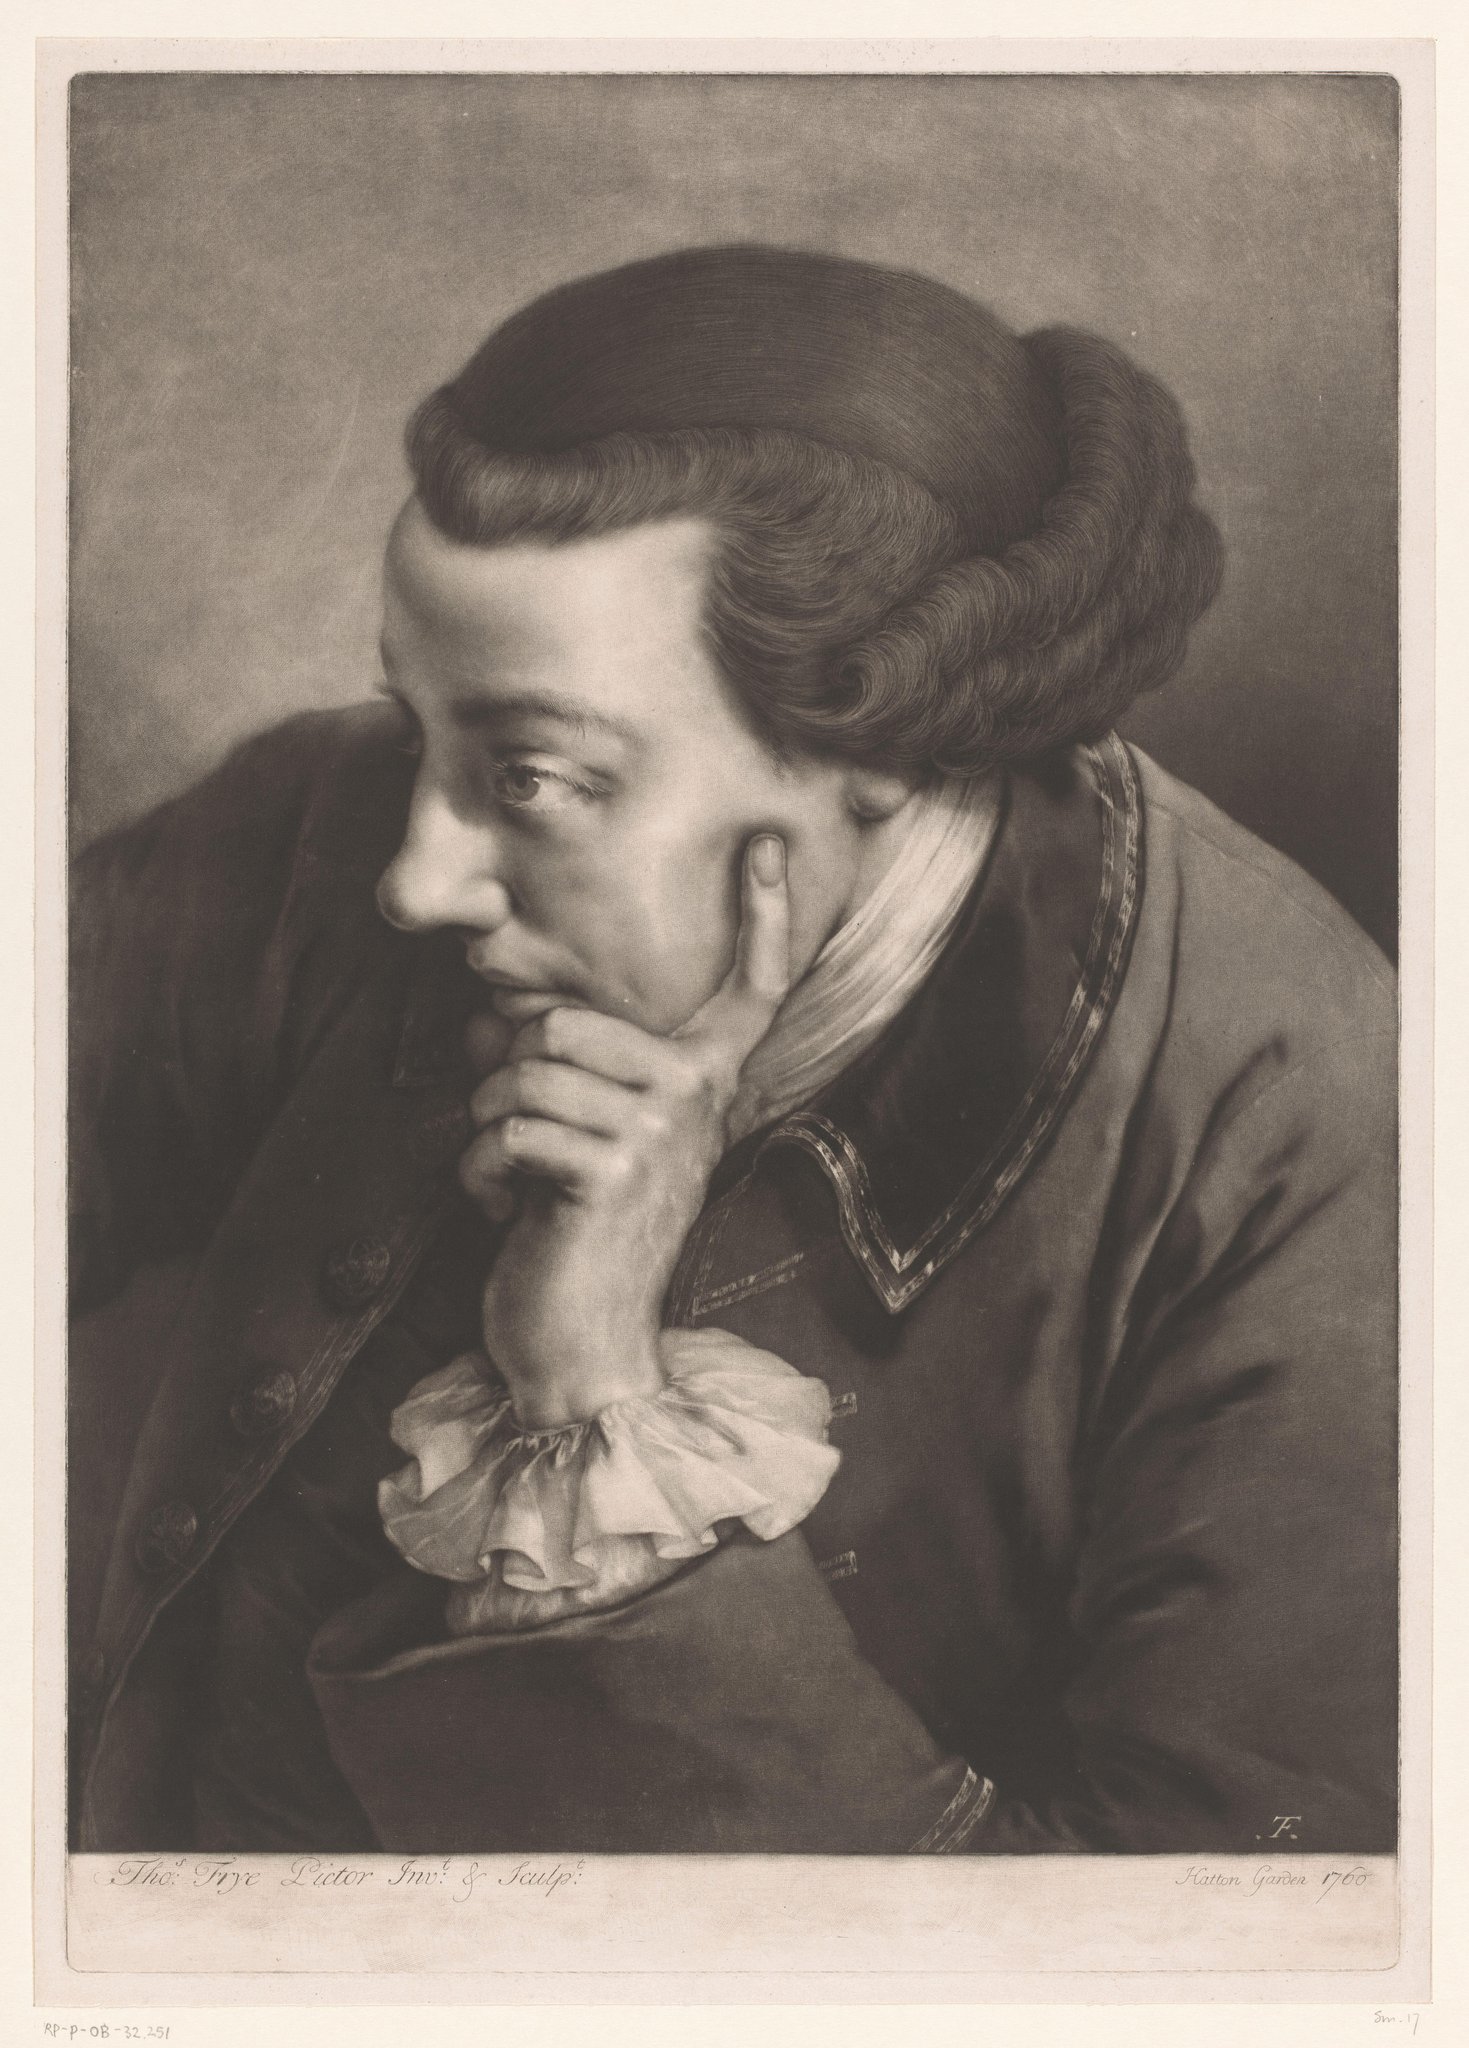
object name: print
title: Life-sized Heads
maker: thomas frye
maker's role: print maker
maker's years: 1710-1762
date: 1760-1762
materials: paper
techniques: mezzotint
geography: london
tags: adult man, leaning figure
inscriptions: collector's mark: Lugt 240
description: Frye voerde portretten uit in olieverf, pastel en mezzotint. Deze prent is deel van een serie van achttien levensgrote koppen met verschillende uitdrukkingen en in verschillende houdingen, uitgegeven tussen 1760-1762.